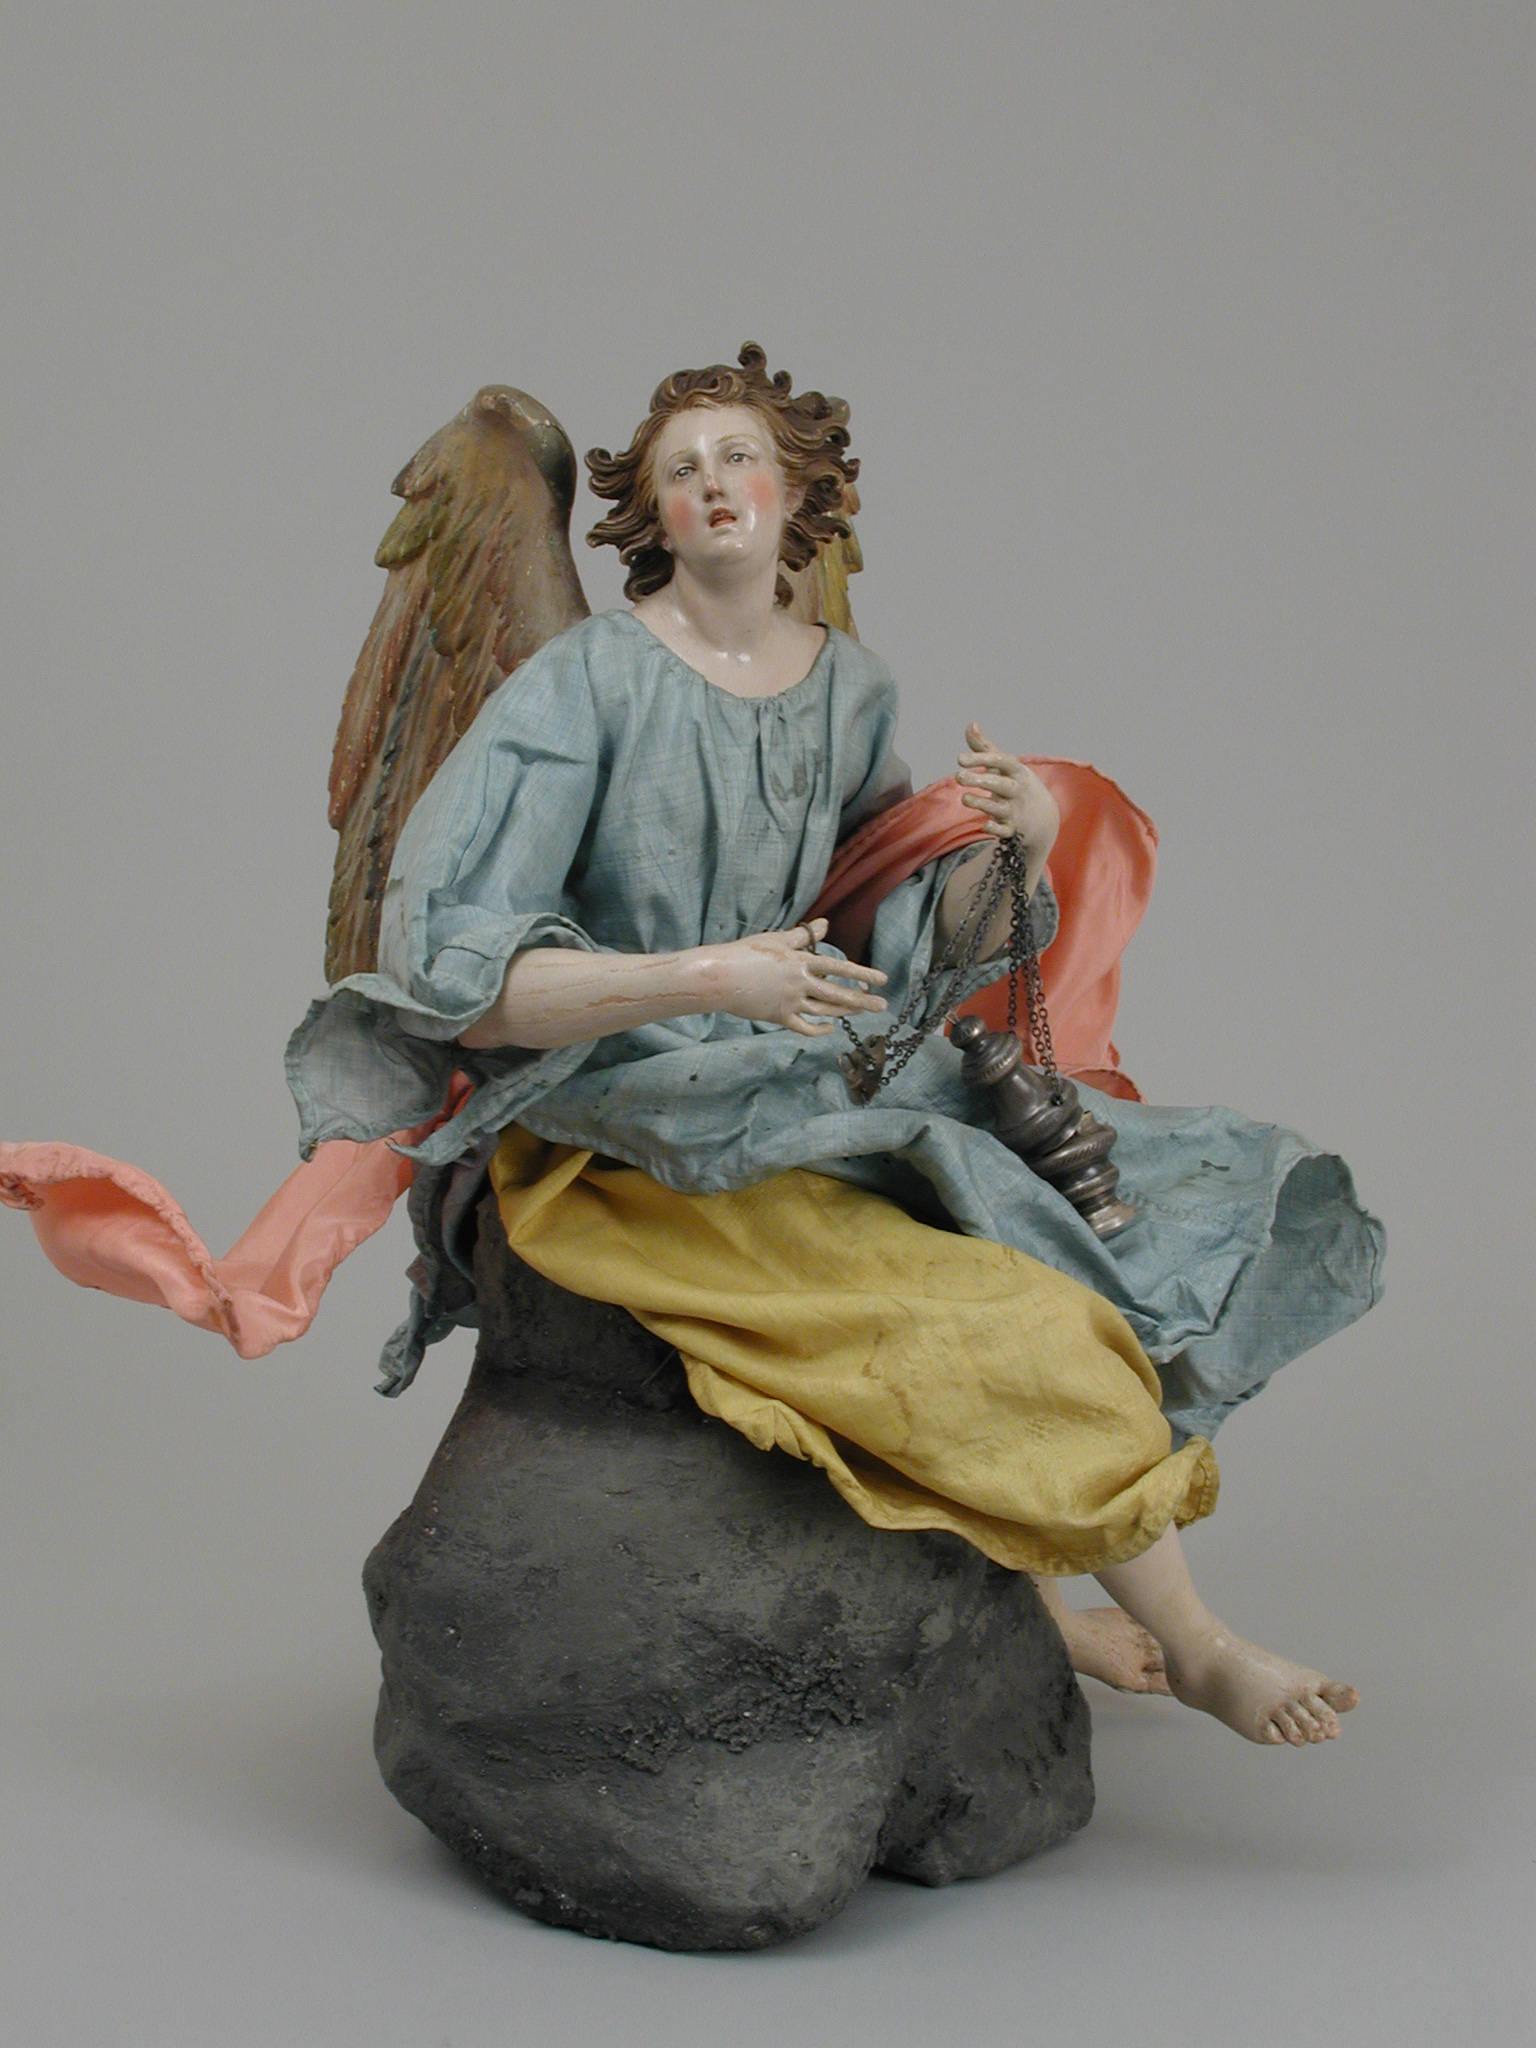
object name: crèche figure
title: Angel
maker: giuseppe gori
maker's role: maker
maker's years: 1770-1810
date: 1751-1800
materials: terracotta, fiber, metal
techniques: polychrome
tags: angels,censers